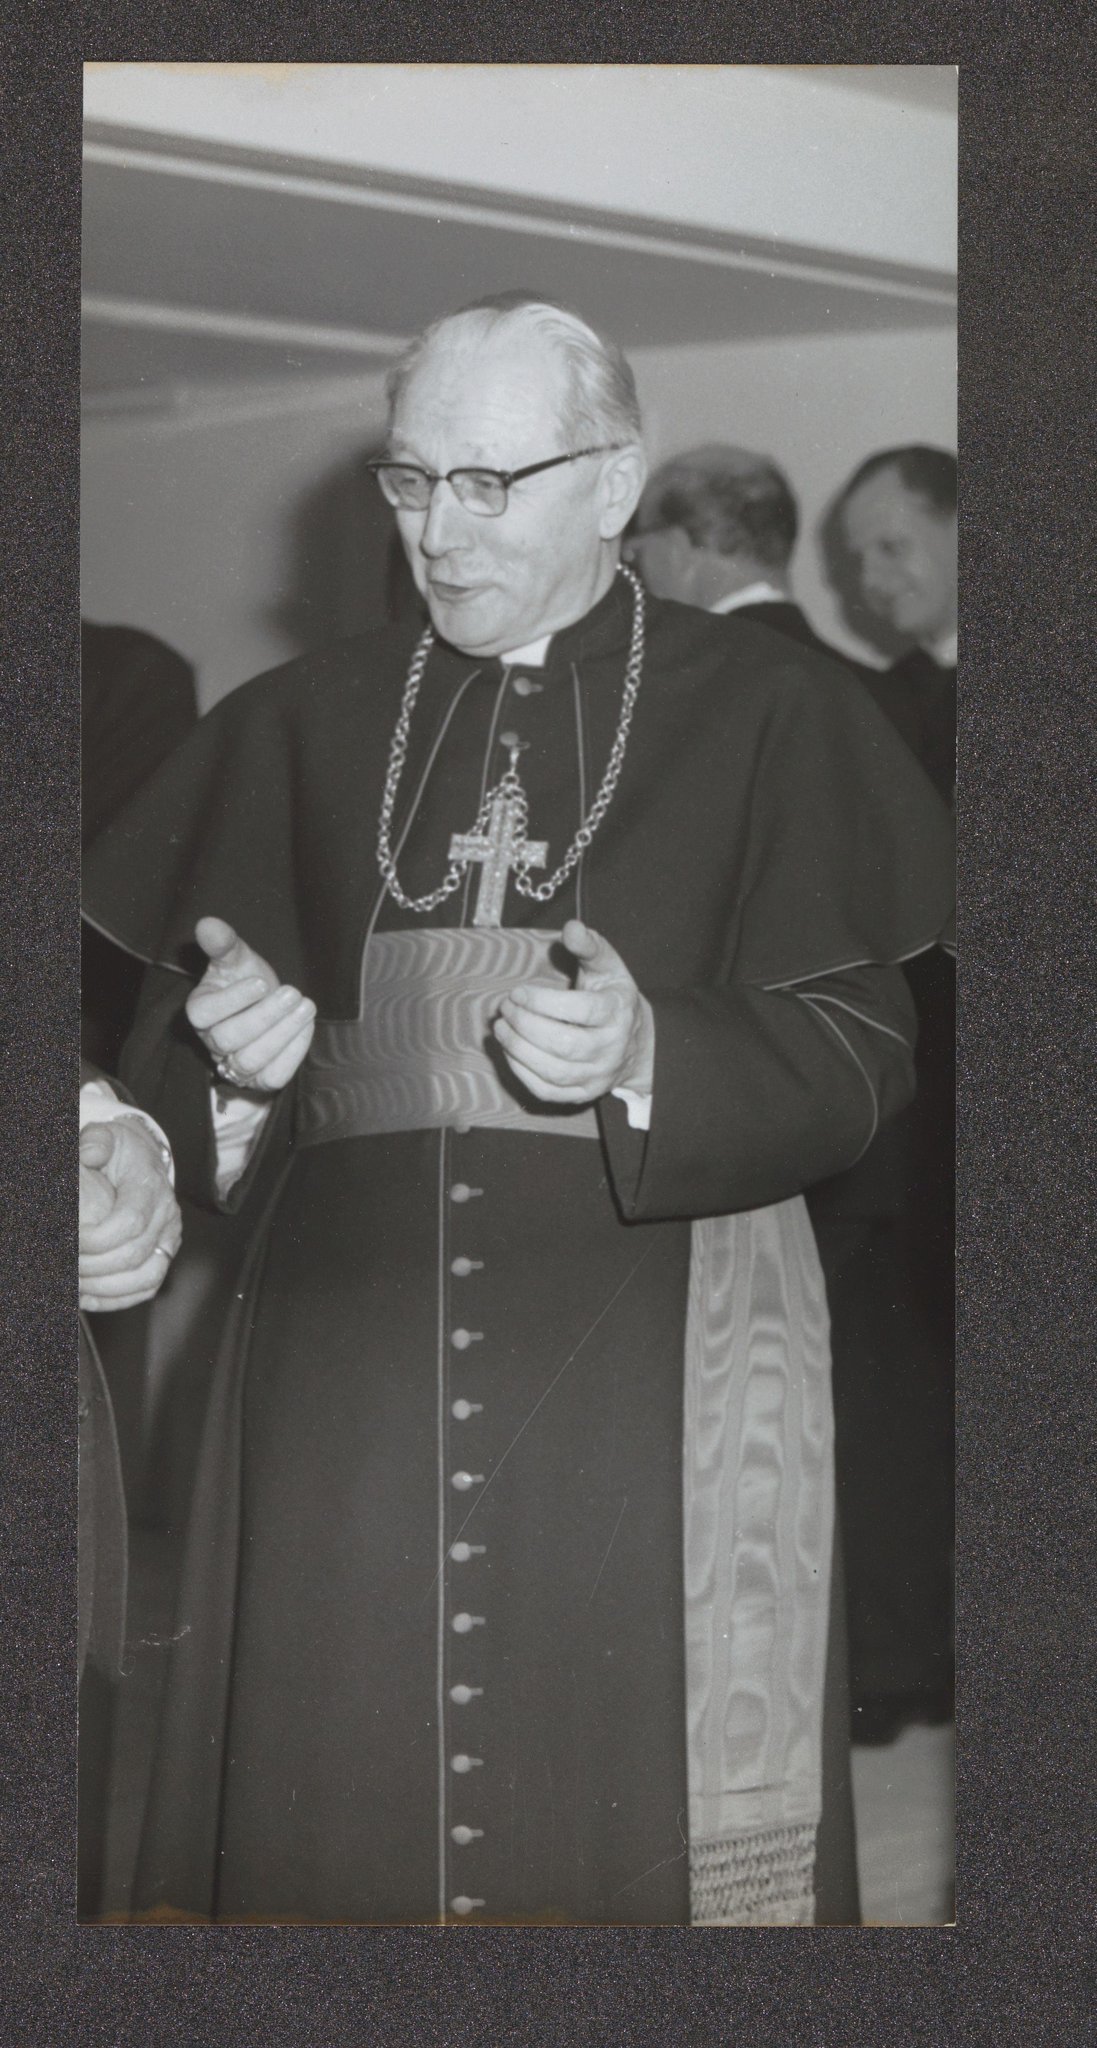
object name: photograph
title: Portret van kardinaal Alfrink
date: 1959-1964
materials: paper, photographic support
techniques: gelatin silver print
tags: nijkerk (gld), kardinaal, hoogleraar, aartsbisschop, bernardus johannes alfrink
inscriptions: inscription: ‘The marriage of Princess Irene and Don Carlos will take place in Holland, both the religious as the civil marriage. Besides the Cathedral Church at Breda for the solemnization of the wedding, the Cahpel of Cardinal Alfrink is mentioned.’